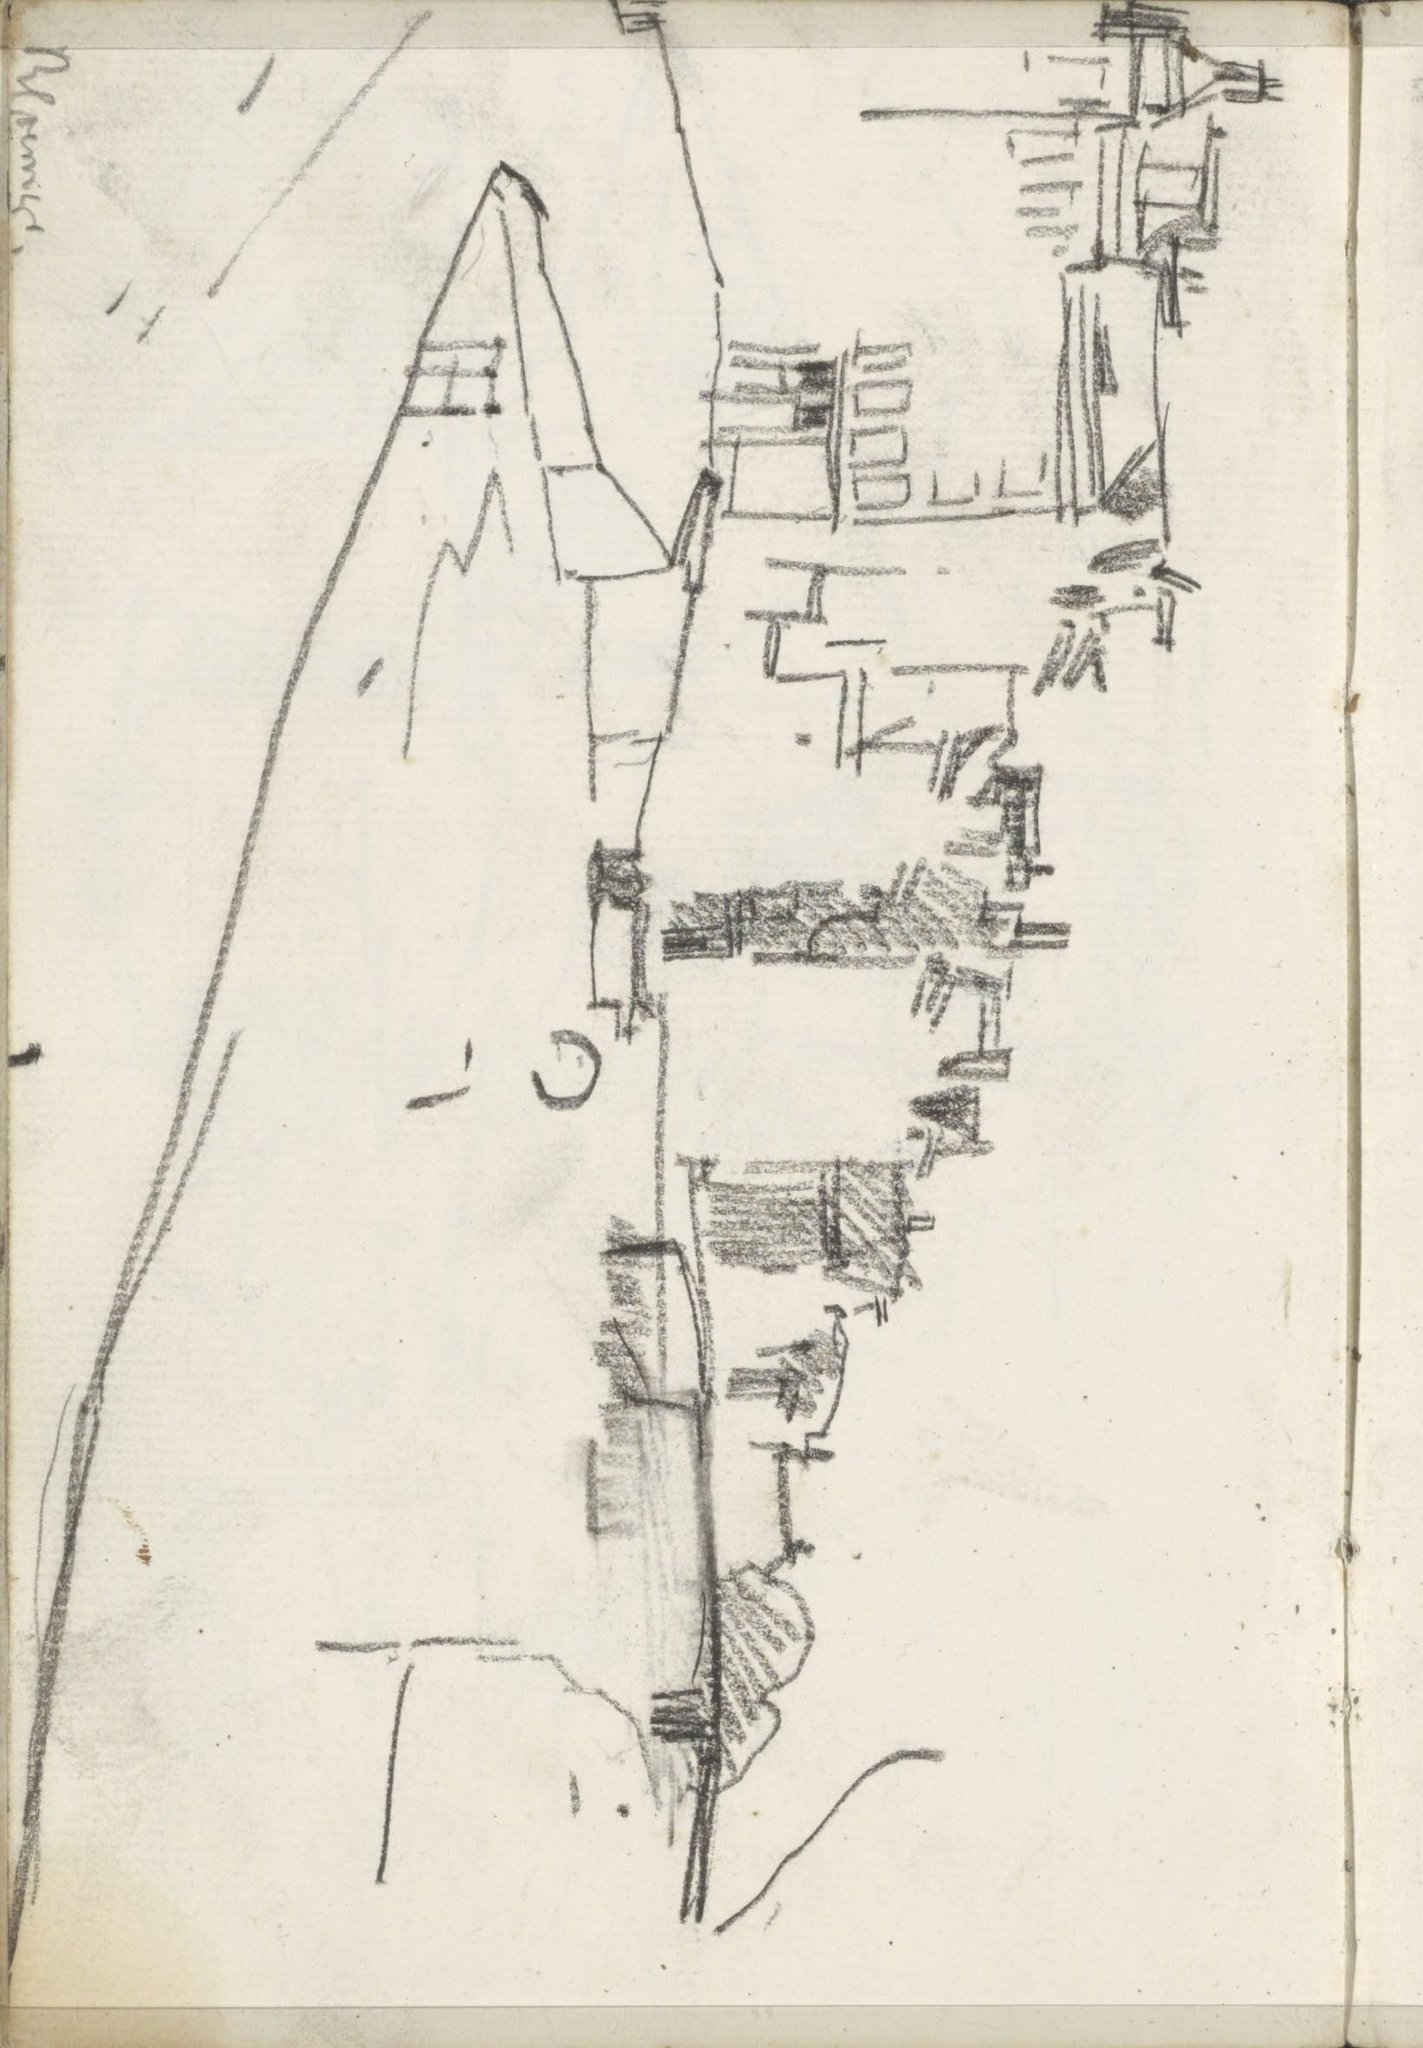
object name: sketchbook leaf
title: Gezicht op de Bloemgracht in Amsterdam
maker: george hendrik breitner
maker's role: draughtsman, painter, print maker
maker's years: 1857-1923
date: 1895-1898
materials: chalk, paper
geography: amsterdam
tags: canals, waters (in city), civic architecture; edifices; dwellings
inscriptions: annotation: ‘Bloemgr.’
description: Pagina 37 uit een schetsboek met 21 bladen.